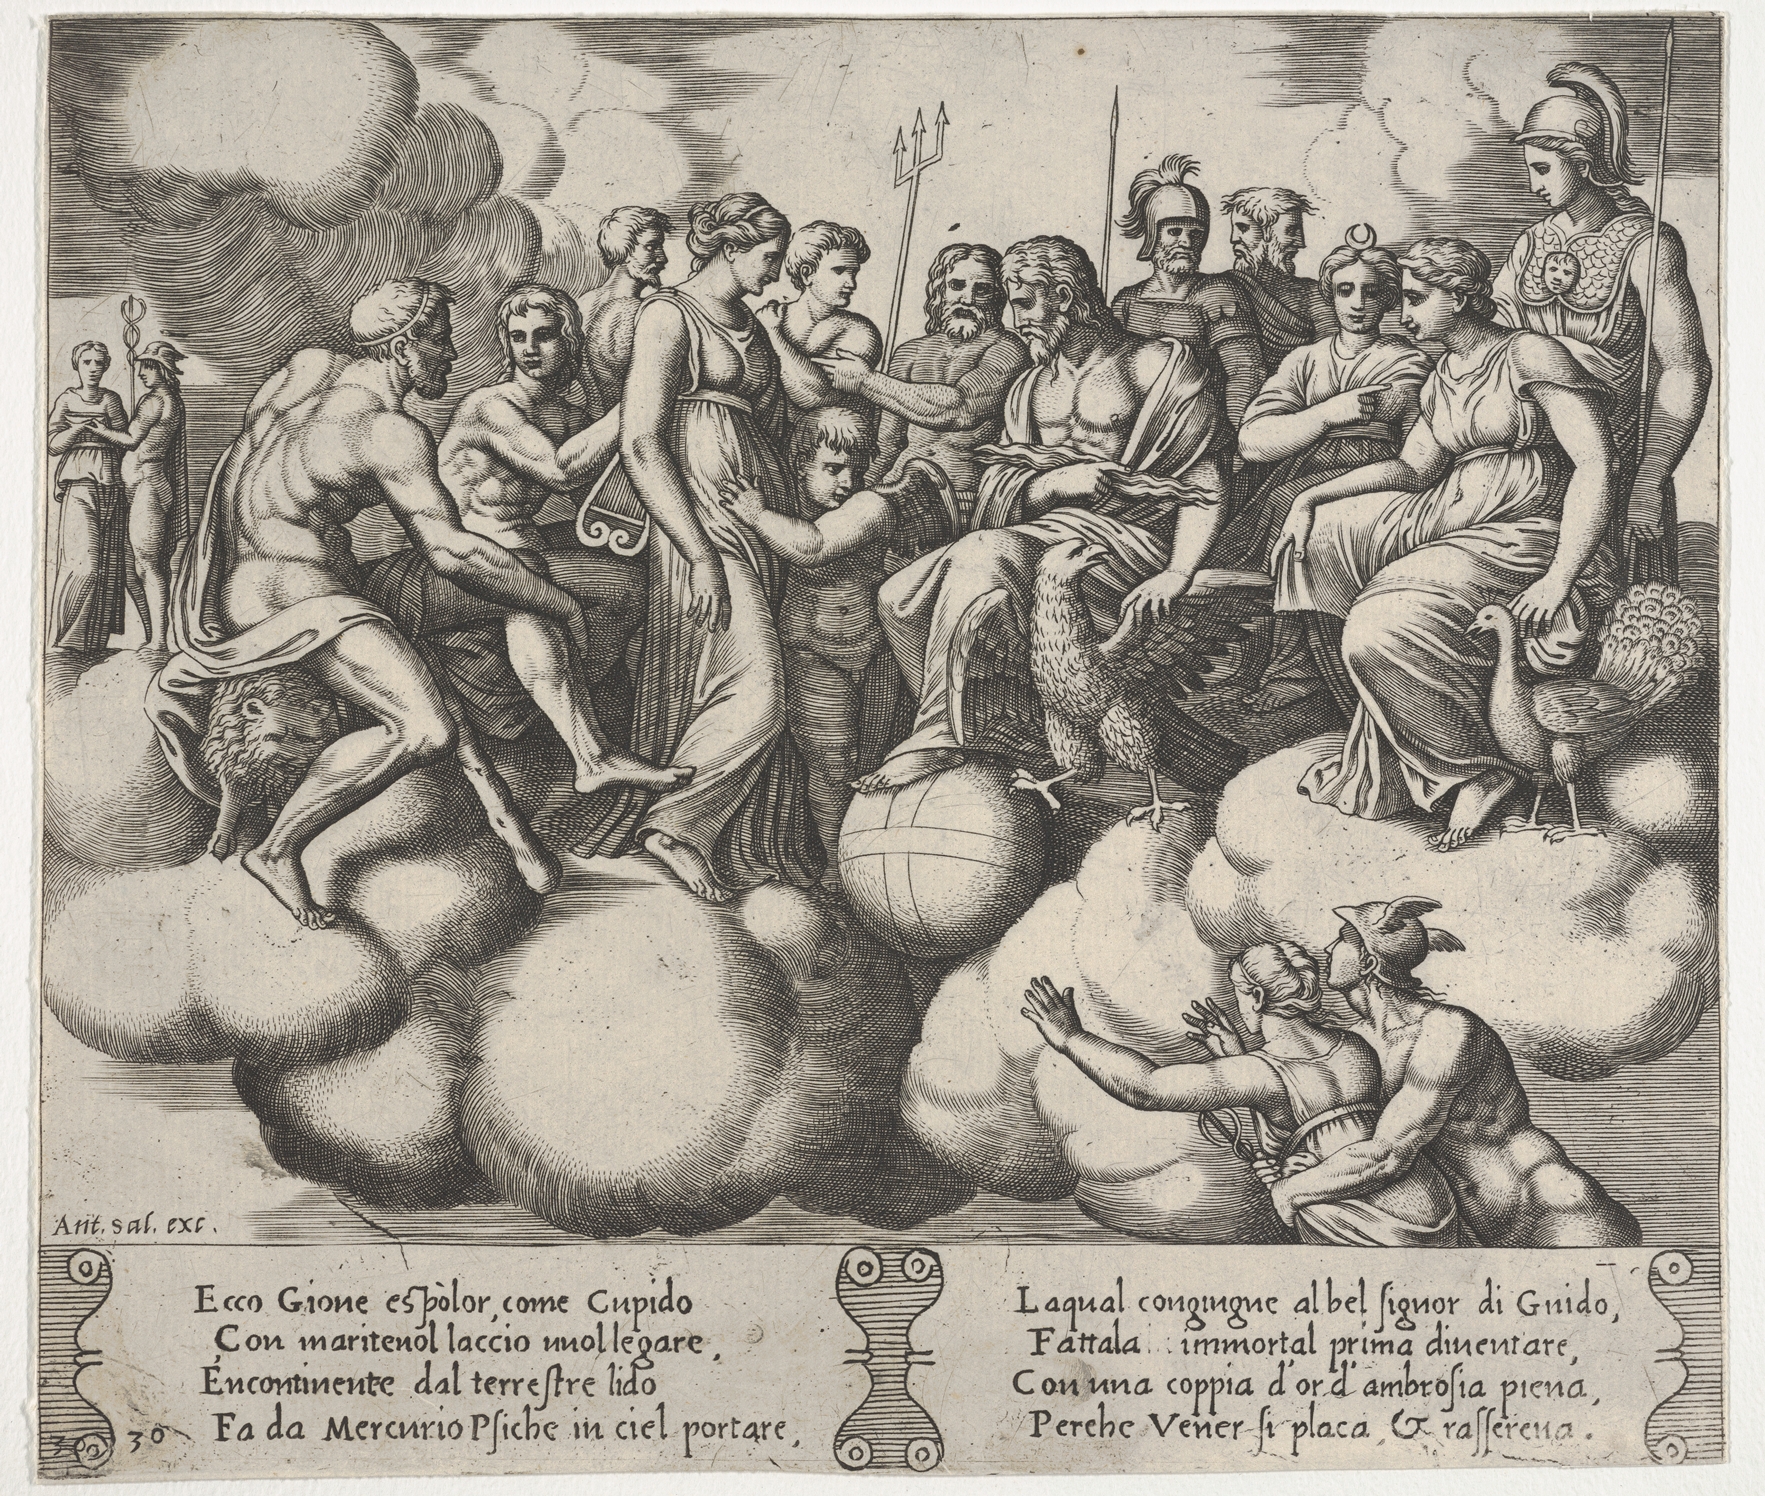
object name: print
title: Plate 30: Cupid and Psyche plead their cases before the Gods, from "The Fable of Cupid and Psyche"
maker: master of the die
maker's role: artist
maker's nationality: italian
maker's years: 1525-1560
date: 1530-1560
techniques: engraving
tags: eagles,cupid,psyche